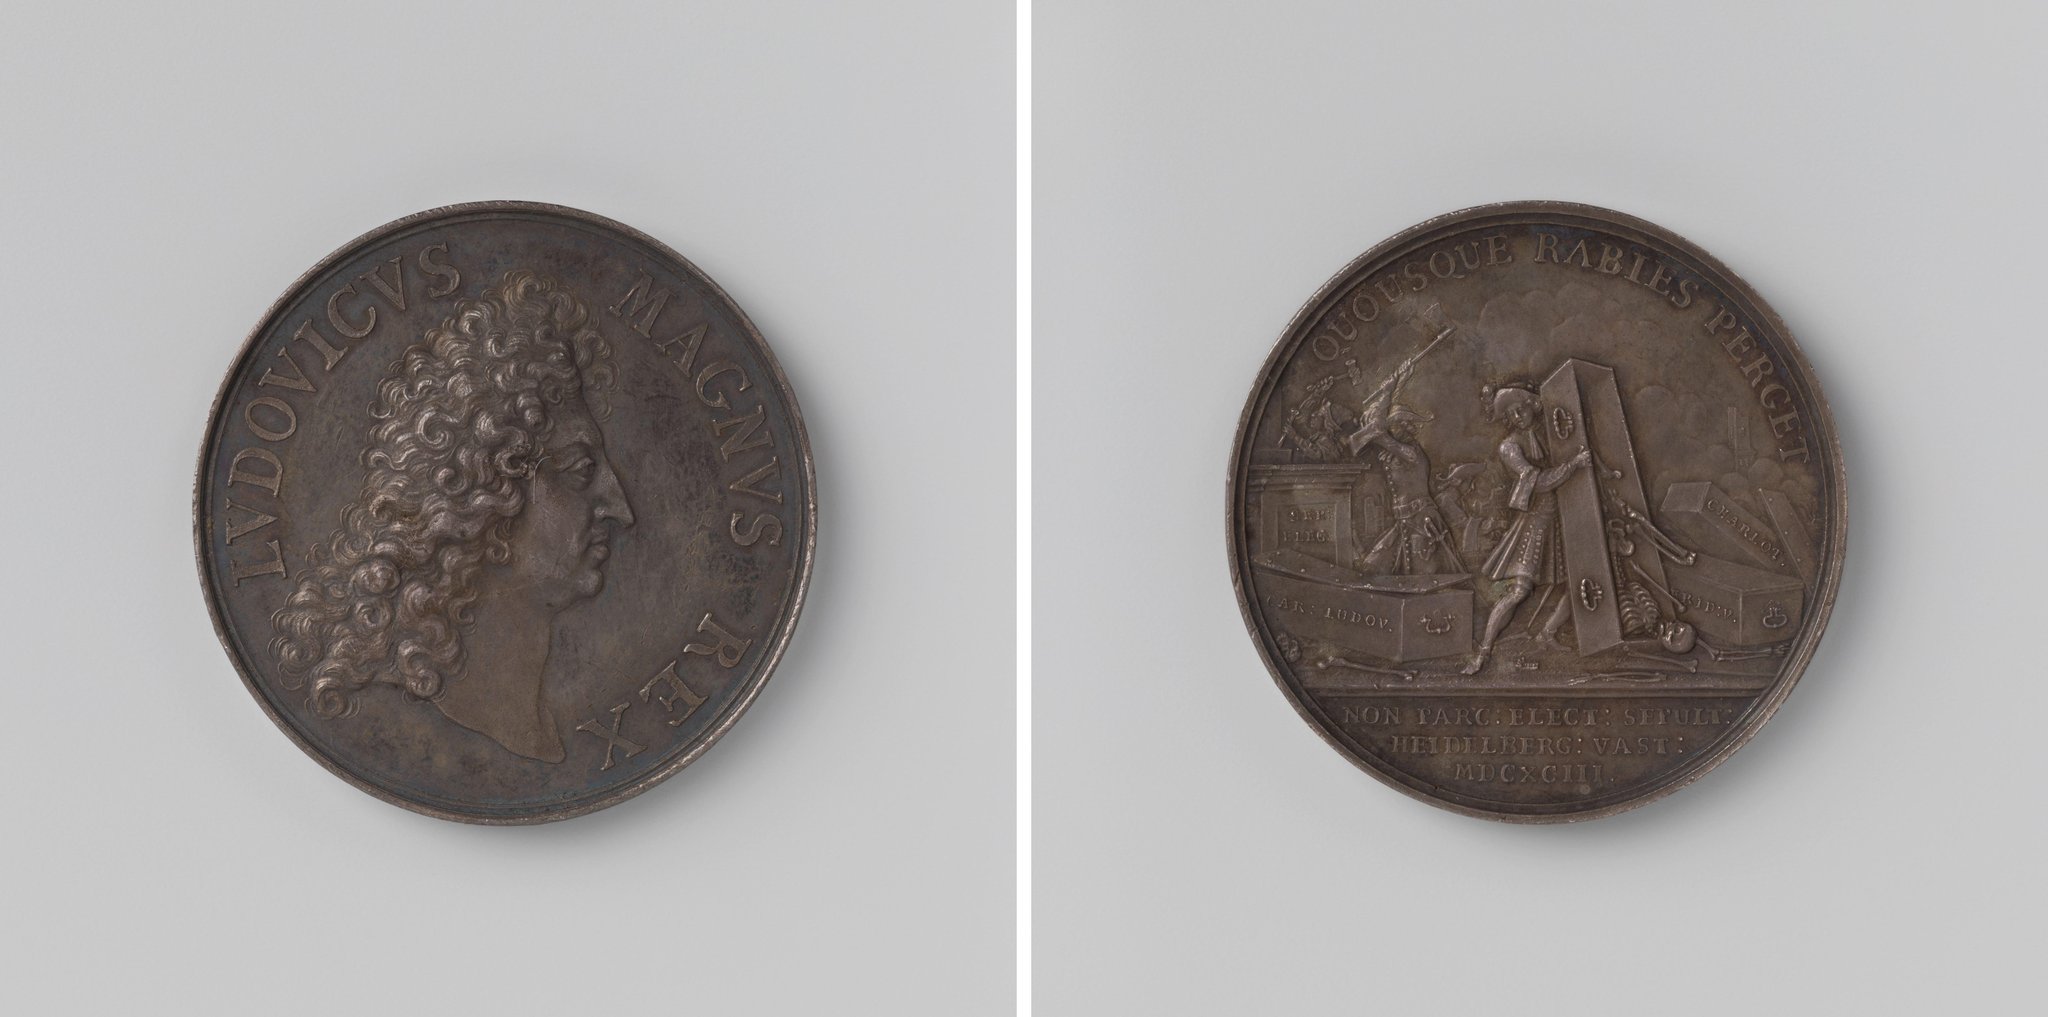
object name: history medal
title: Verwoesting van Heidelberg en schending van de keurvorstelijke graven door de Fransen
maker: jan smeltzing (i)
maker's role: modelleur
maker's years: 1656-1693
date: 1693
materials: silver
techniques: striking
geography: leiden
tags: lodewijk xiv (koning van frankrijk)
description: Zilveren penning. Voorzijde: borststuk man binnen omschrift. Keerzijde: het schenden van de graven door de Franse troepen, op achtergrond brandende stad binnen omschrift; afsnede: opschrift